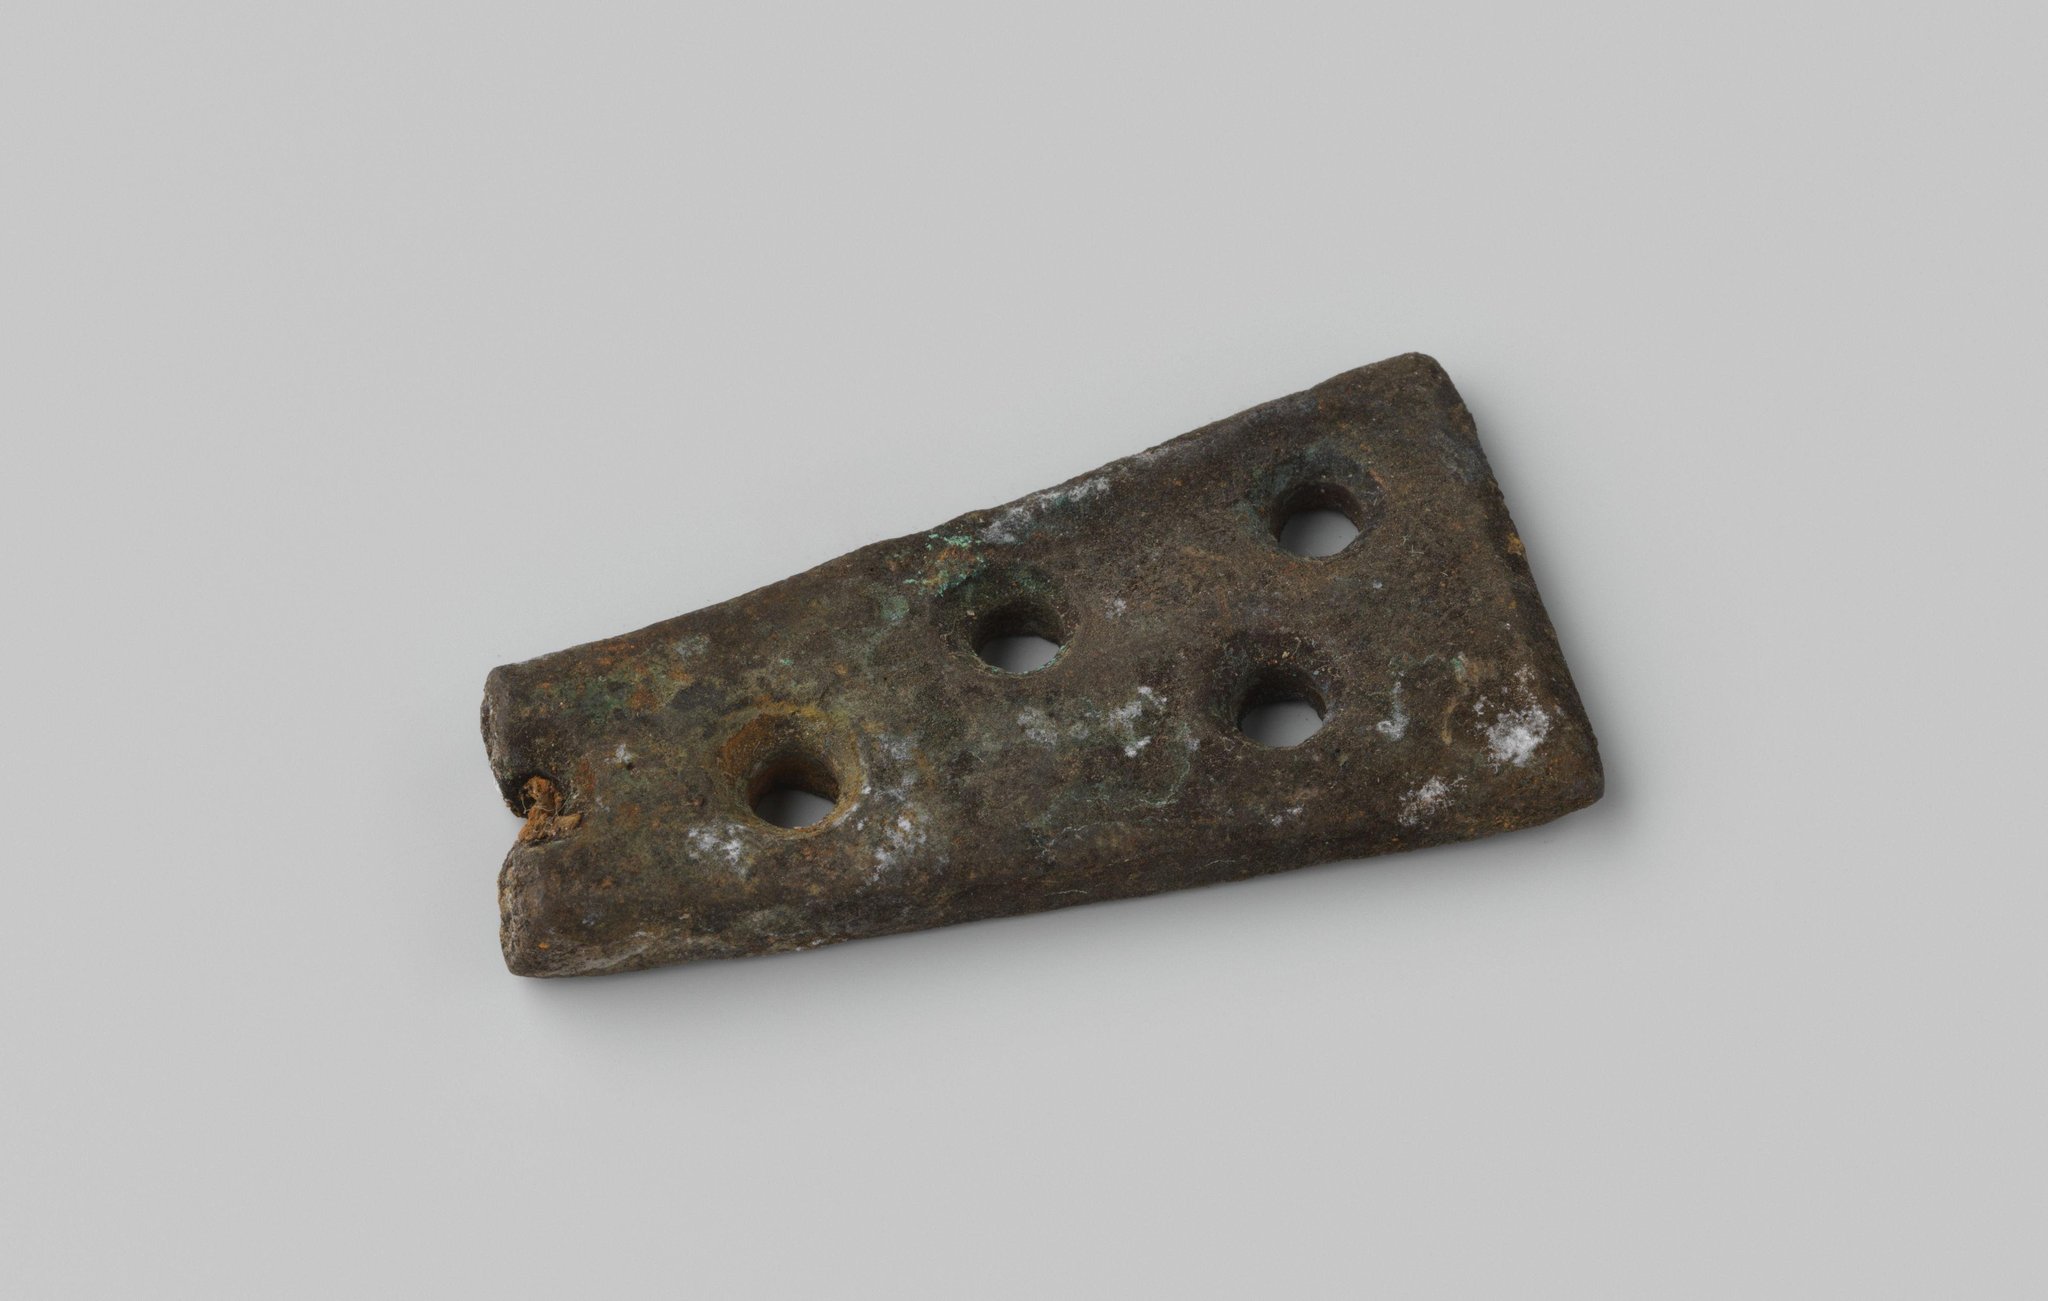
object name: fragment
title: Fragment hoekplaat afkomstig uit het wrak van de Oost-Indiëvaarder Hollandia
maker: Anonymous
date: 1700-1743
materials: copper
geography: netherlands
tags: verenigde oostindische compagnie, hollandia (schip)